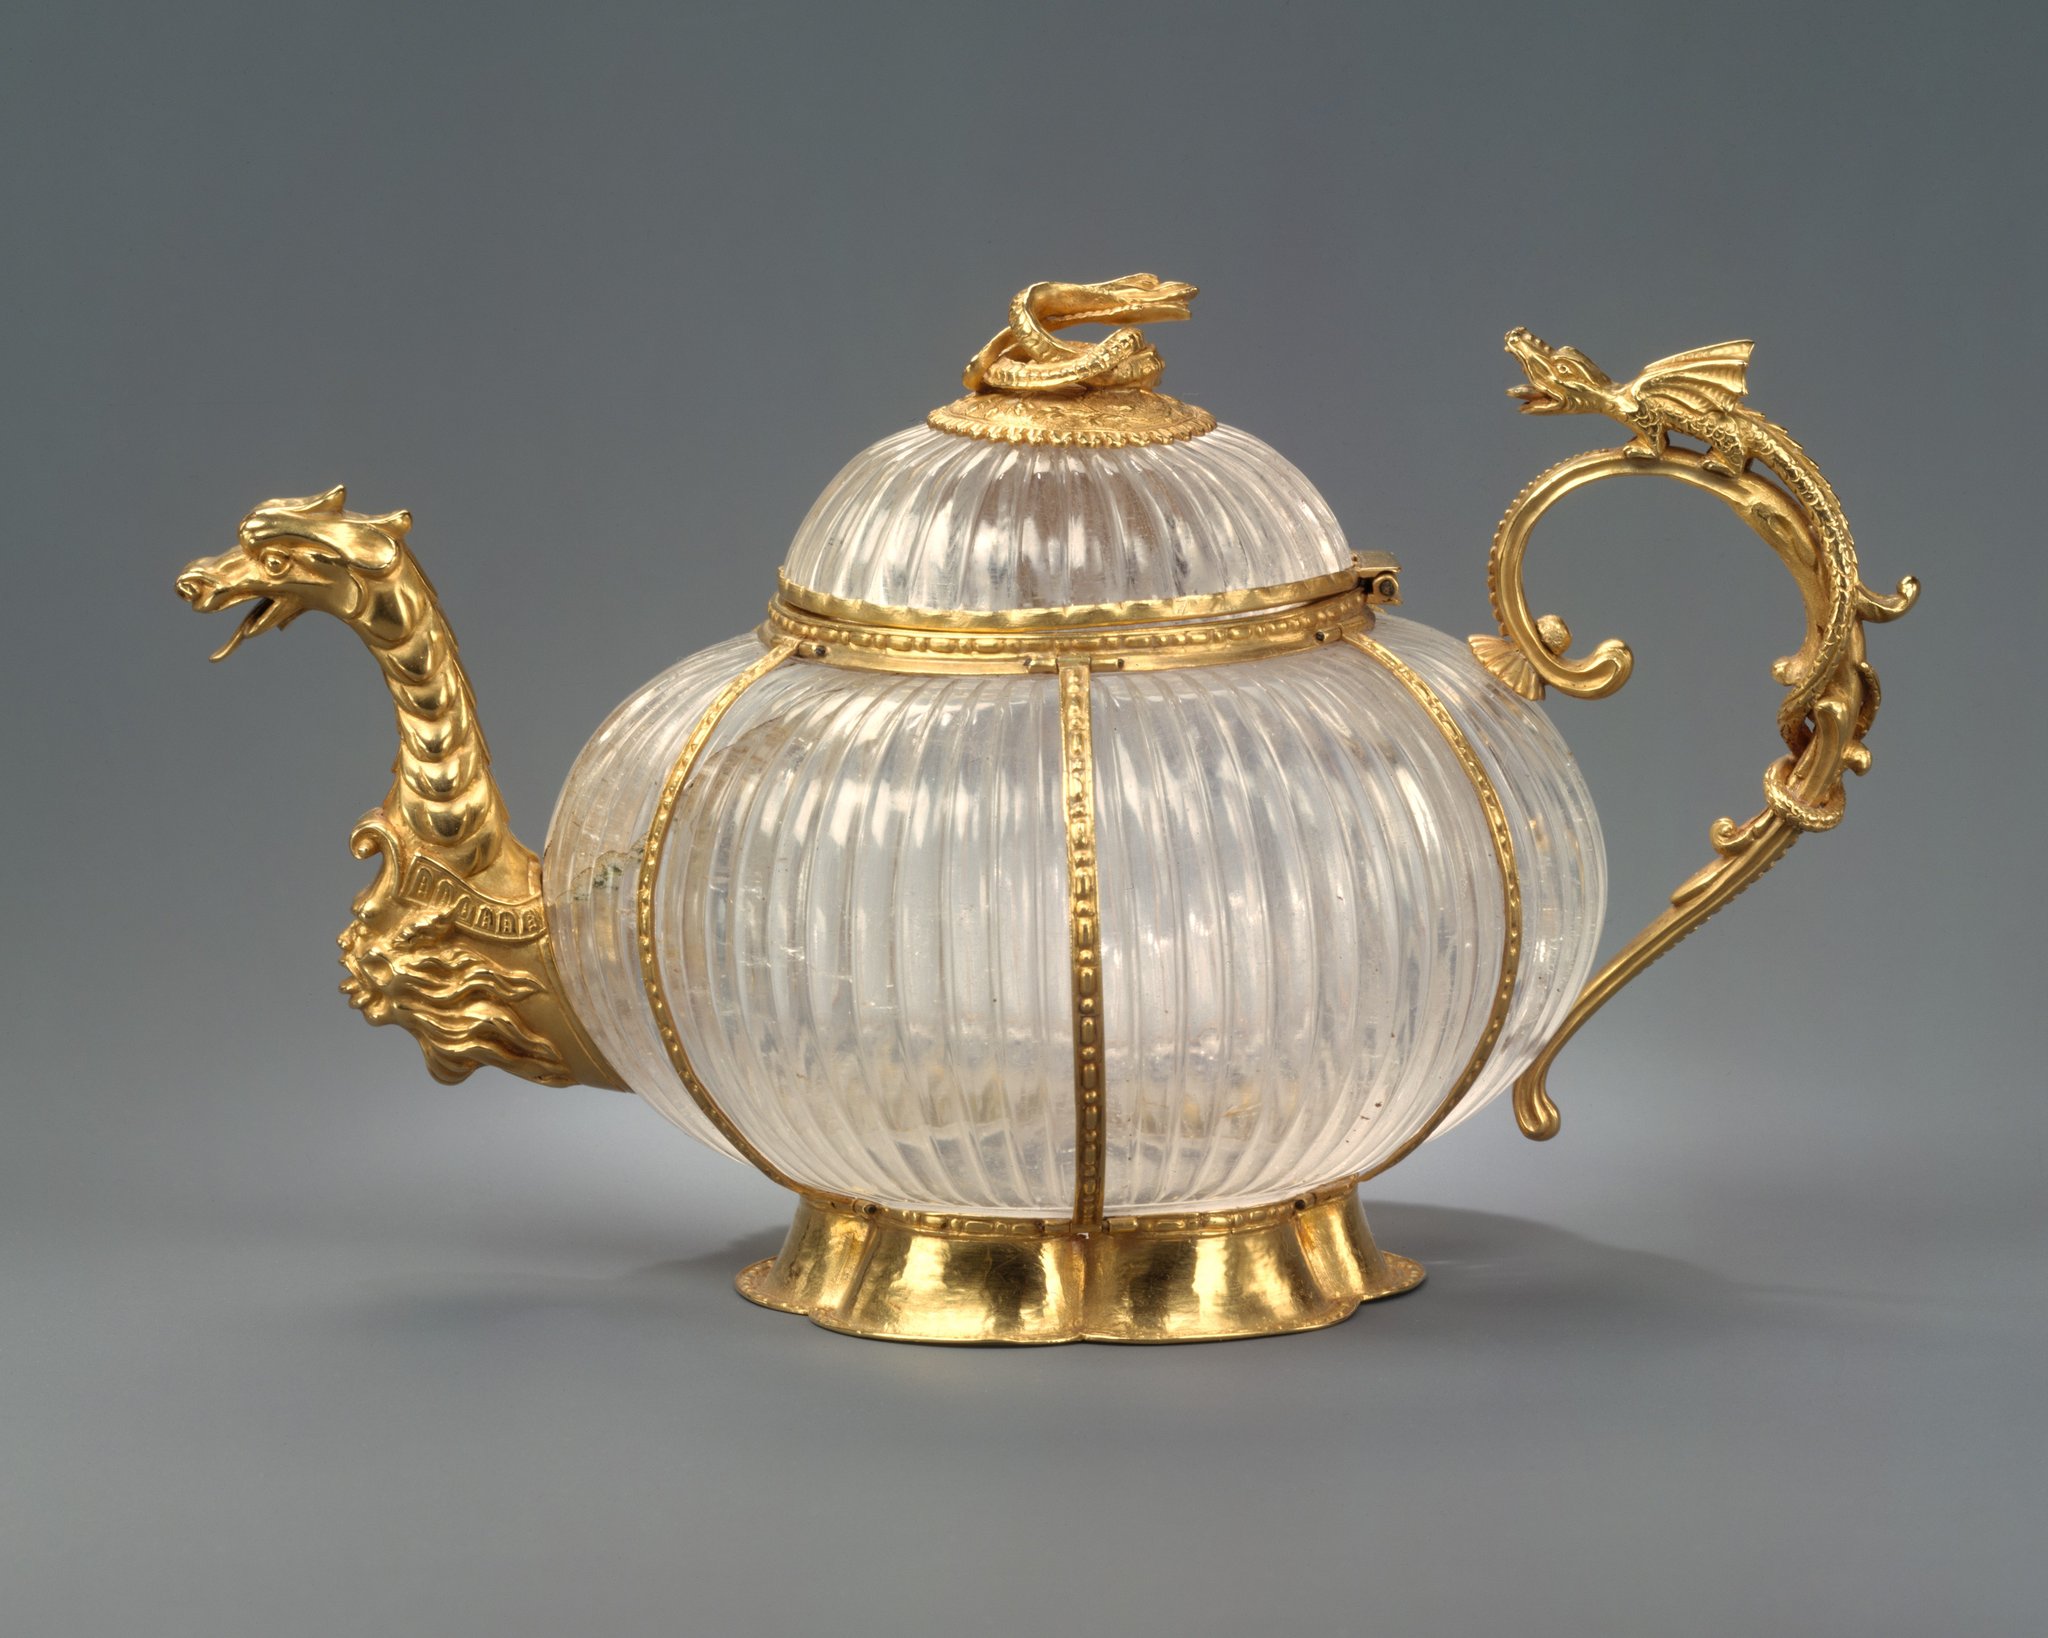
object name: teapot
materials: gold, quartz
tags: dragons